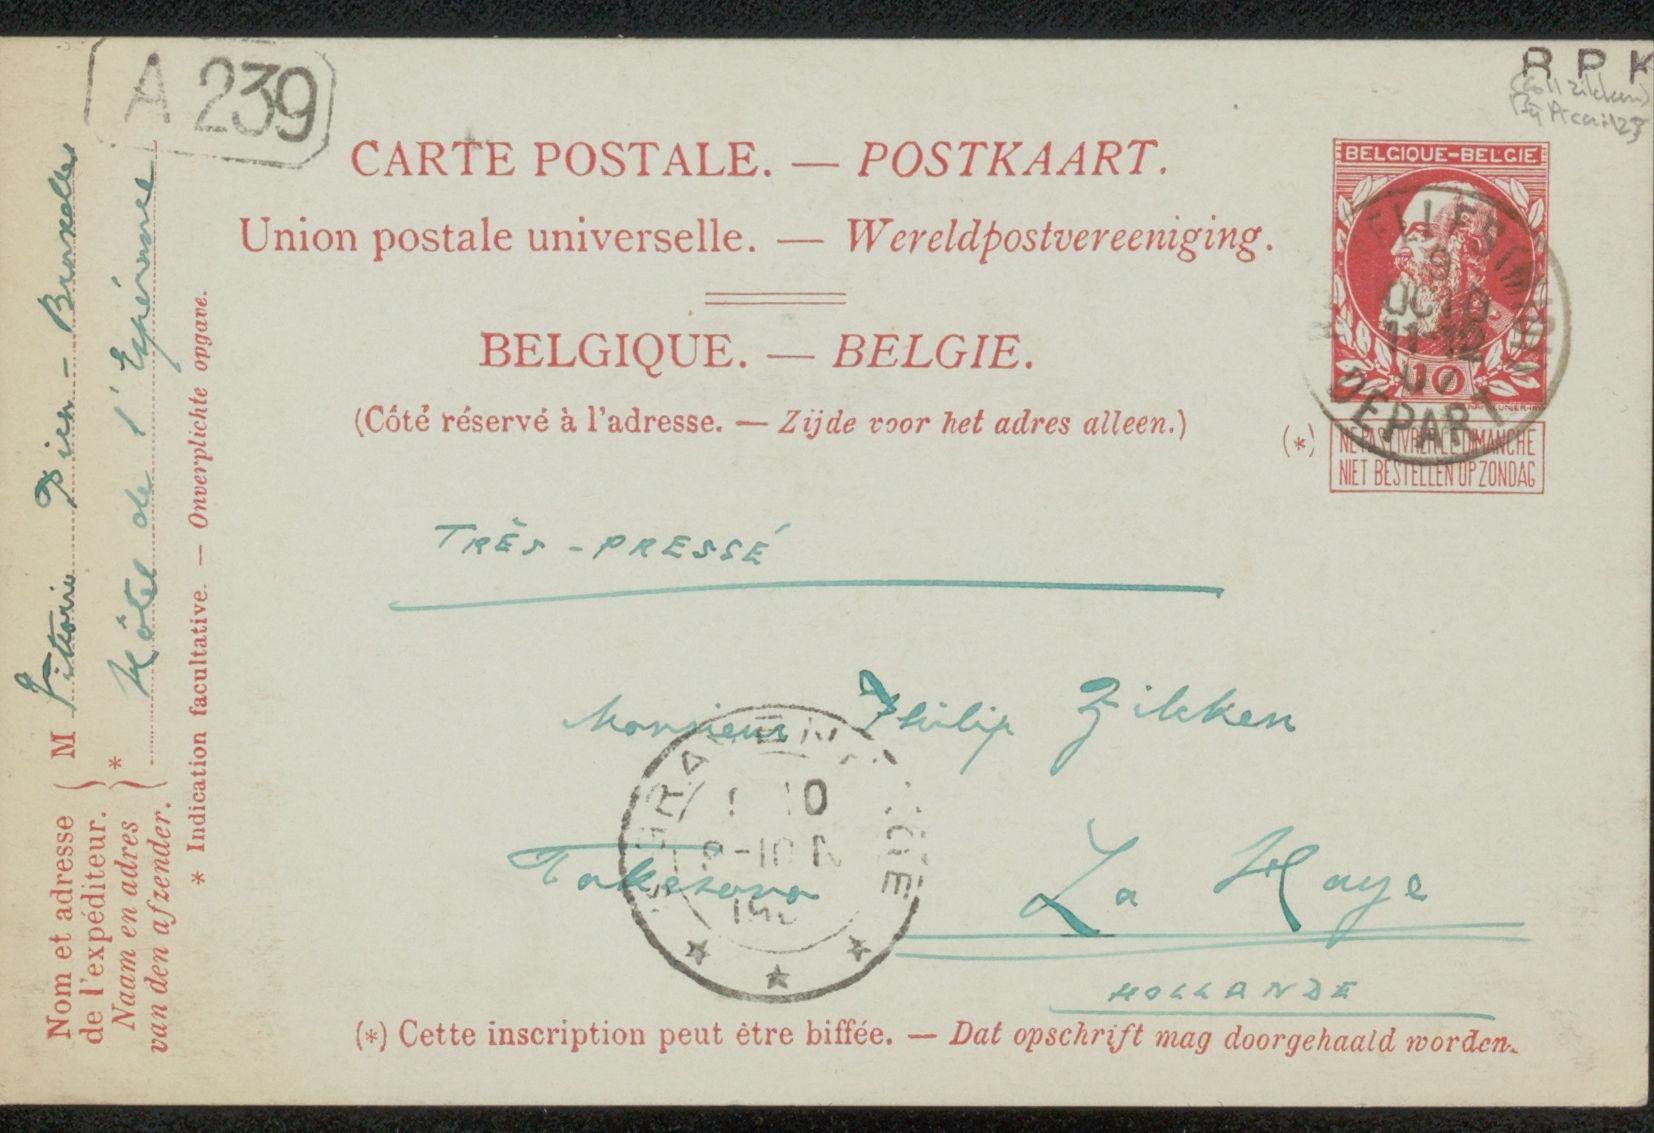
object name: postcard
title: Briefkaart aan Philip Zilcken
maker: vittorio pica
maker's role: criticus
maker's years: 1864-1930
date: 1907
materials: cardboard, ink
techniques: pen, writing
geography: brussels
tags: the hague, draughtsman, philip zilcken, paris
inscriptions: collector's mark: ‘RPK’